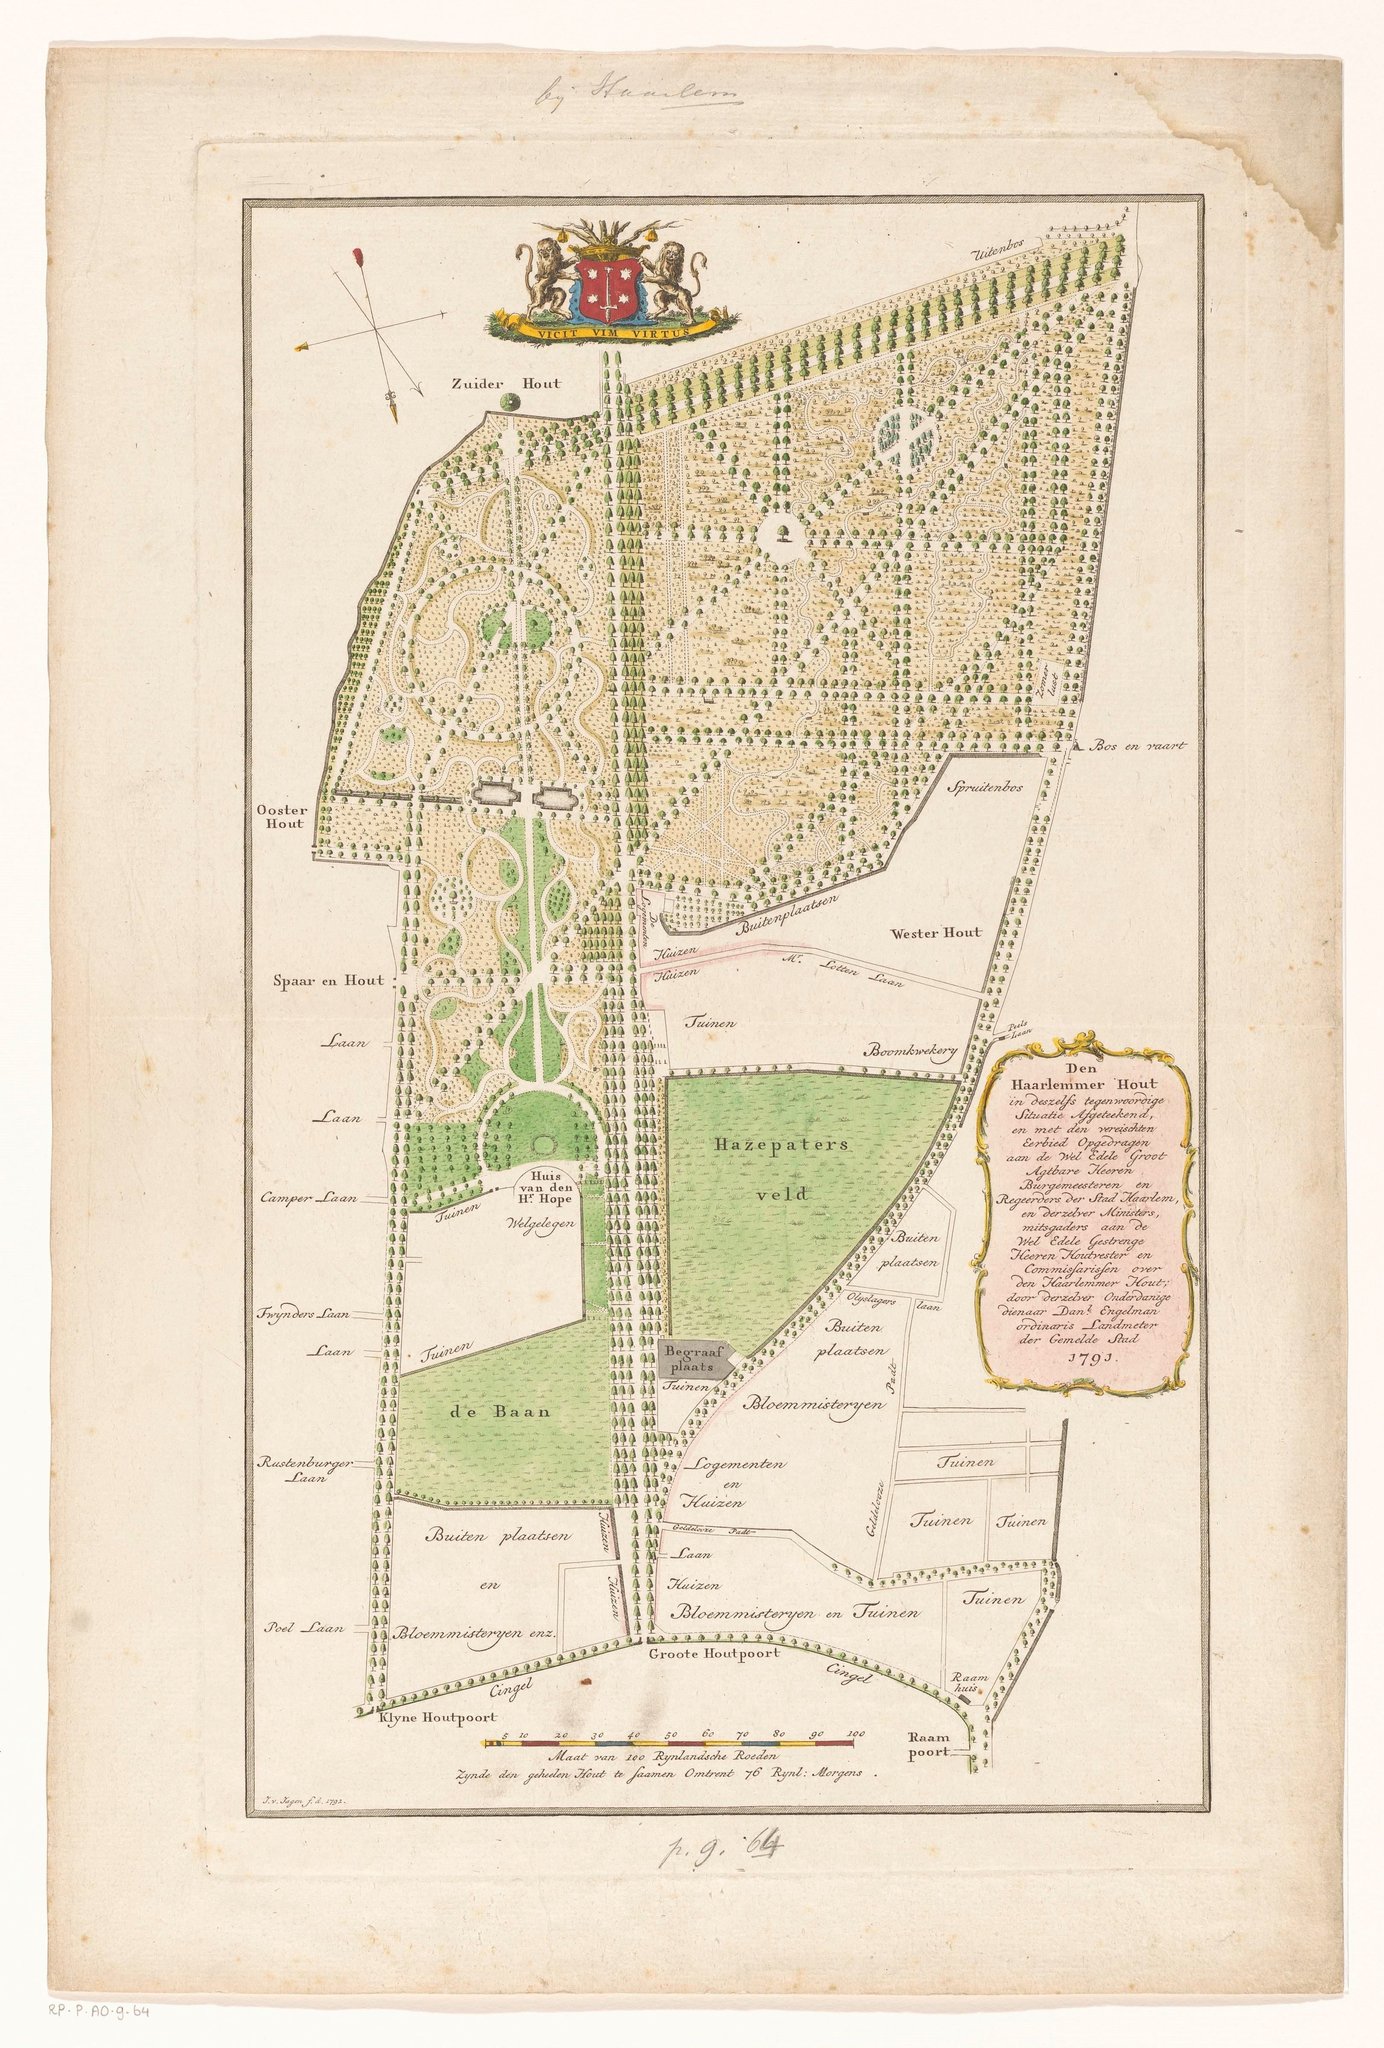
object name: print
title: Den Haarlemmer Hout in deszelfs tegenwoordige situatie afgeteekend …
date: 1792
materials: paper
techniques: engraving, etching, hand coloring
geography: haarlem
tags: coat of arms (as symbol of the state, etc.) (+ city; municipal), maps of separate countries or regions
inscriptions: collector's mark: Lugt 19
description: Plattegrond van de Haarlemmerhout. Boven het wapen van Haarlem. Rechts een cartouche met de titel en de opdracht. Onder een schaalstok: Maat van 100 Rynlandsche roeden zynde den geheelen Hout te saamen omtrent 76 Rynl: morgens.